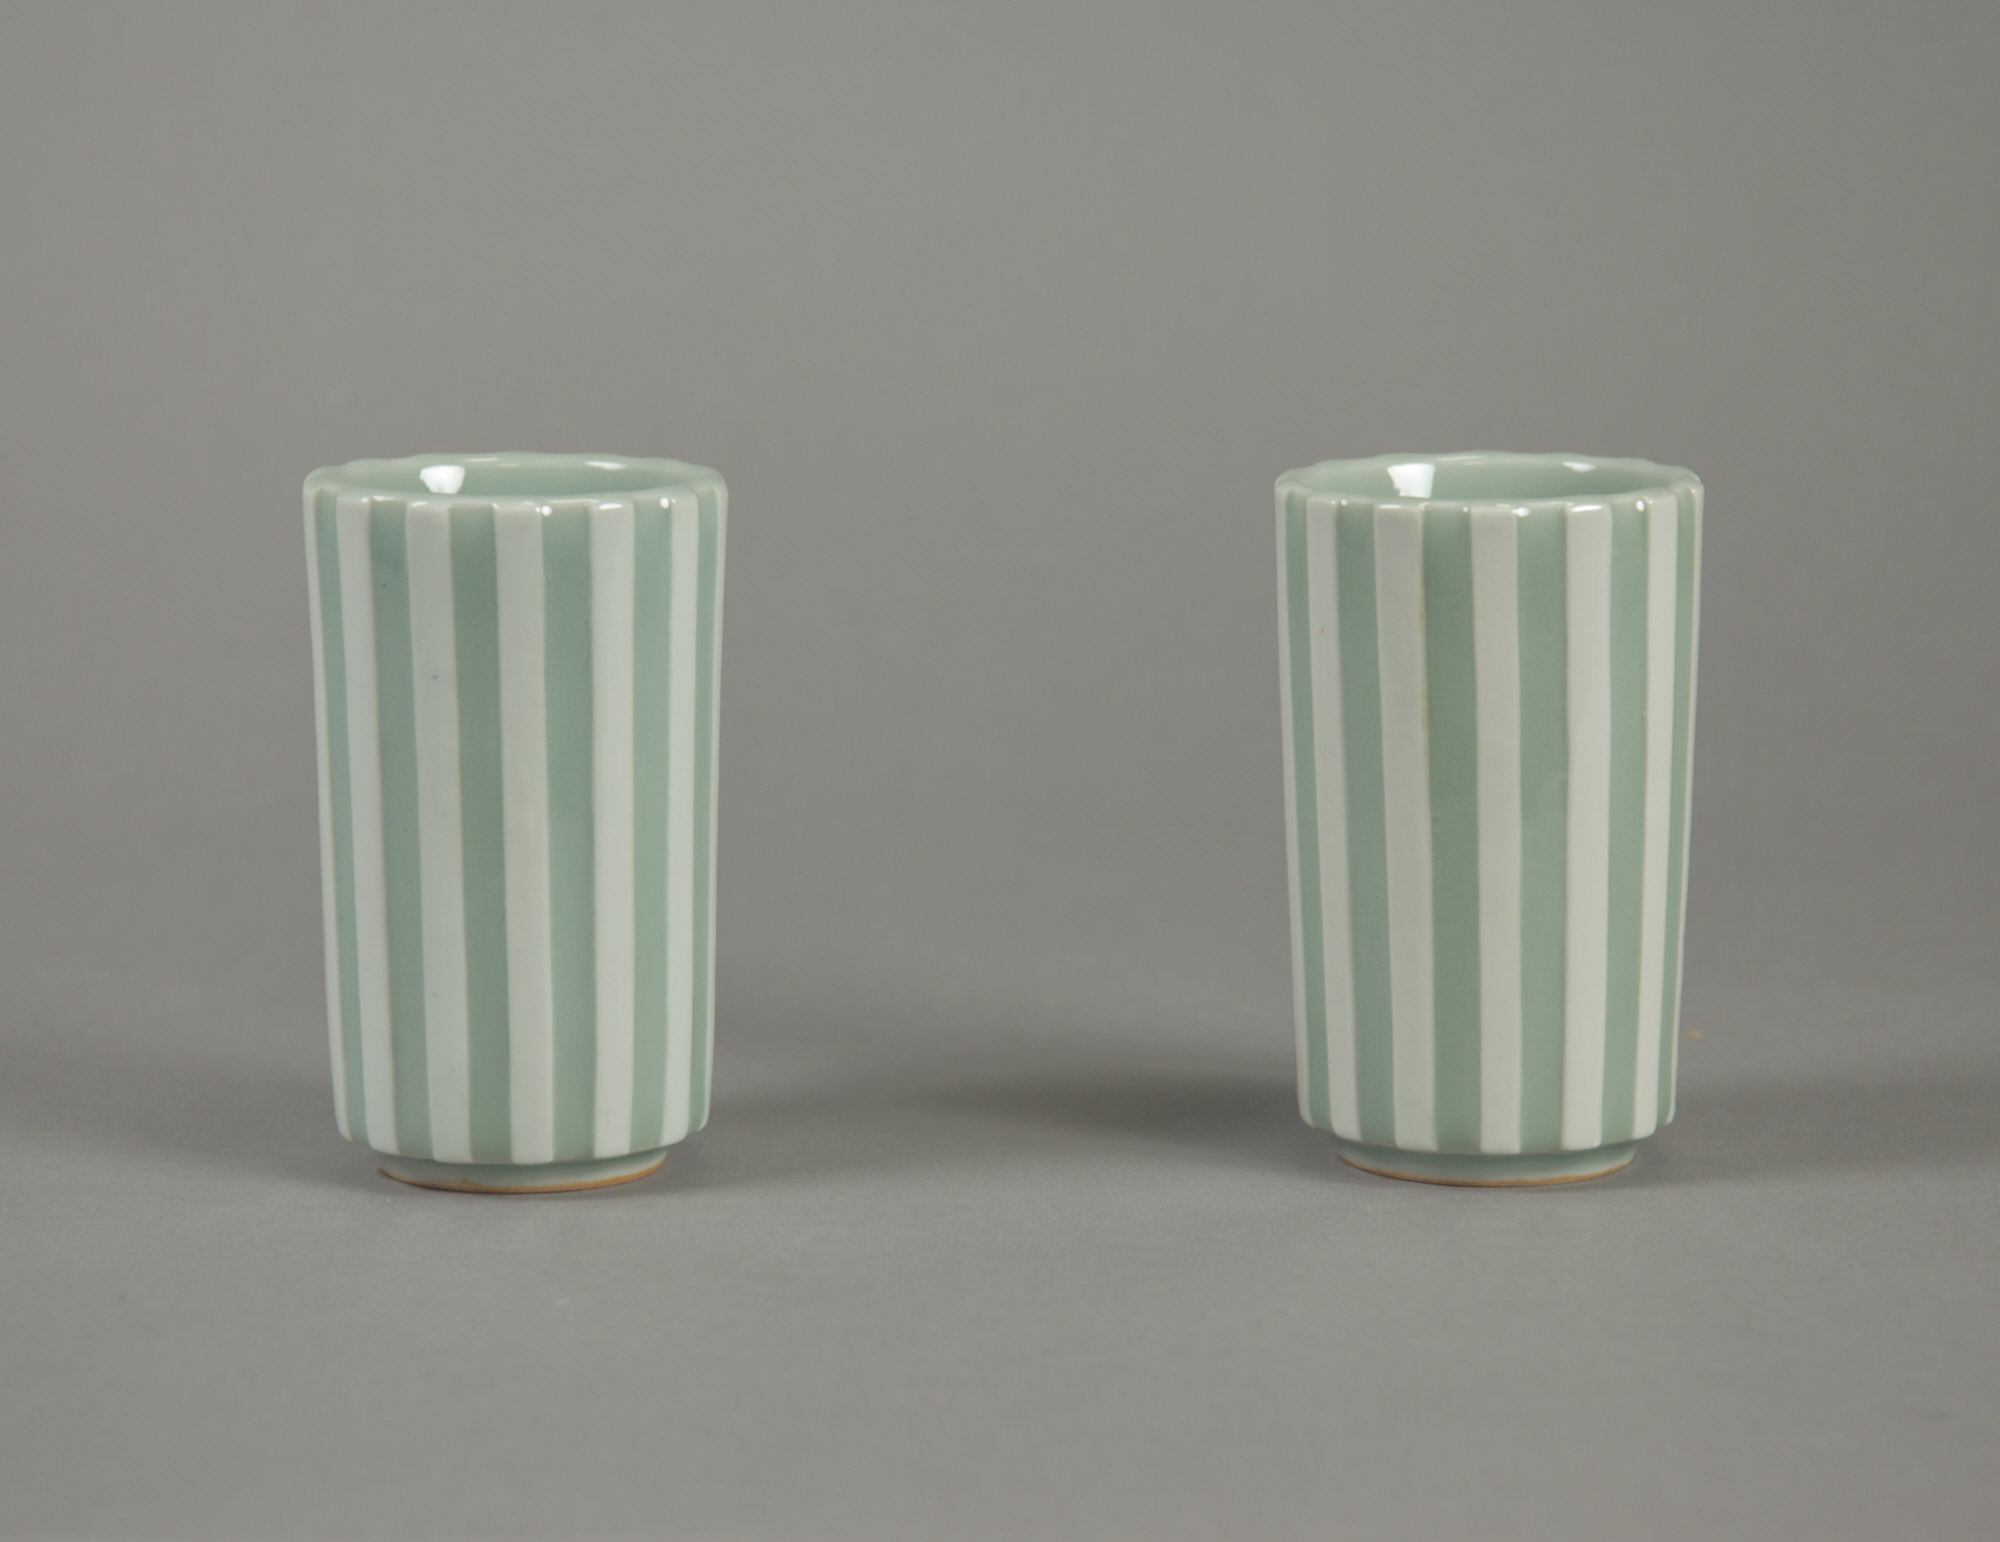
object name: cup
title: Cup with Striped Design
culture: japanese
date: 1701-1800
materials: porcelain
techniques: underglaze